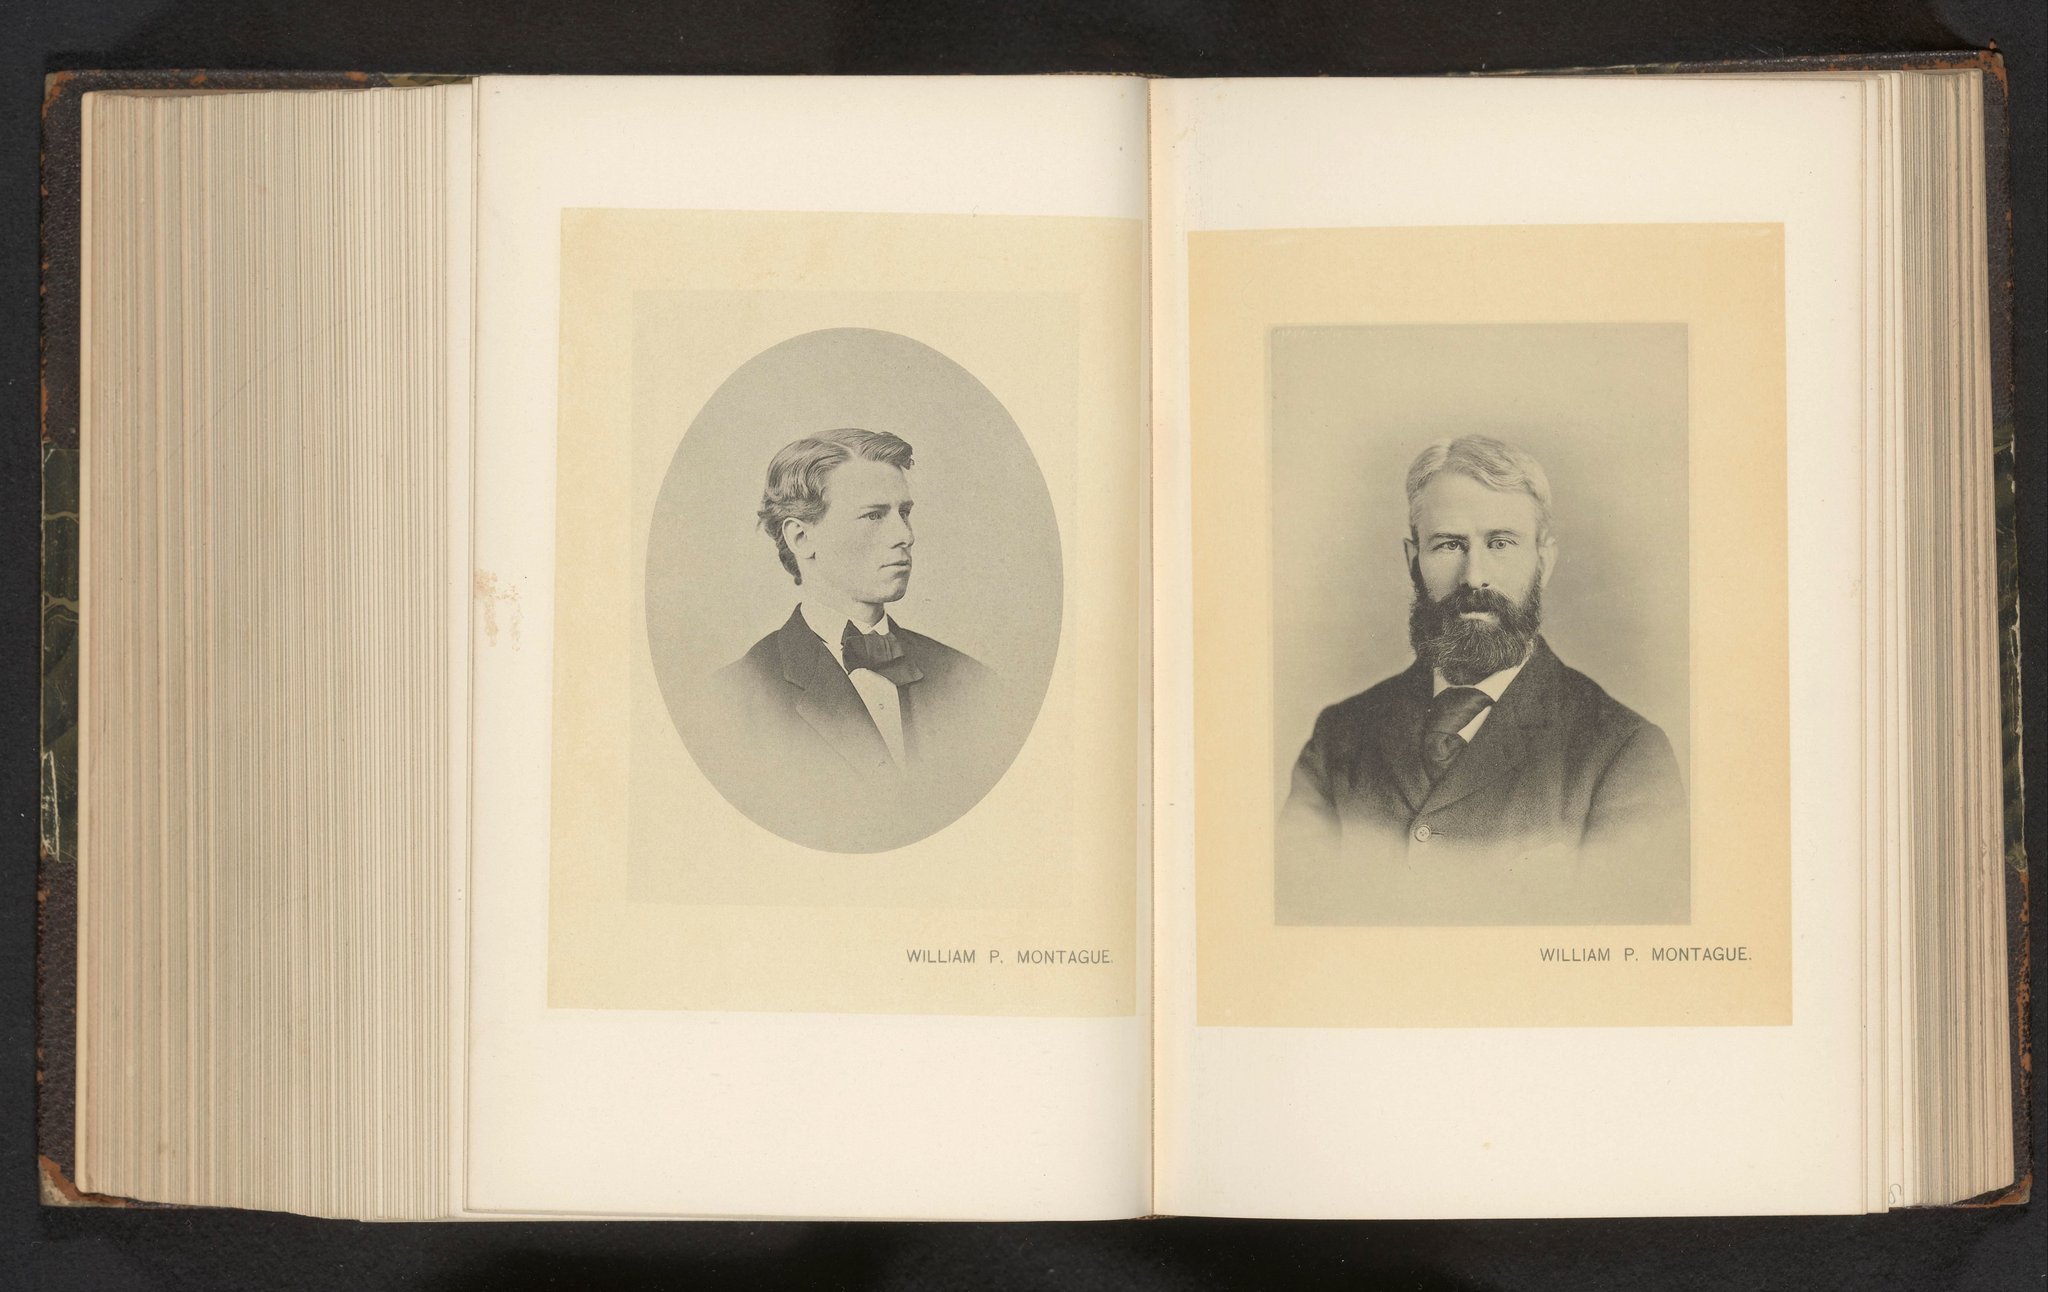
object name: page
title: William P. Montague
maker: Anonymous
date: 1869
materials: paper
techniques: photoaquatint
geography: boston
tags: adult man